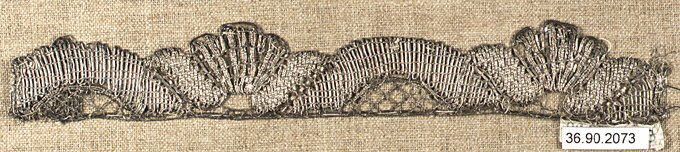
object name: piece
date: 1701-1800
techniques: lace